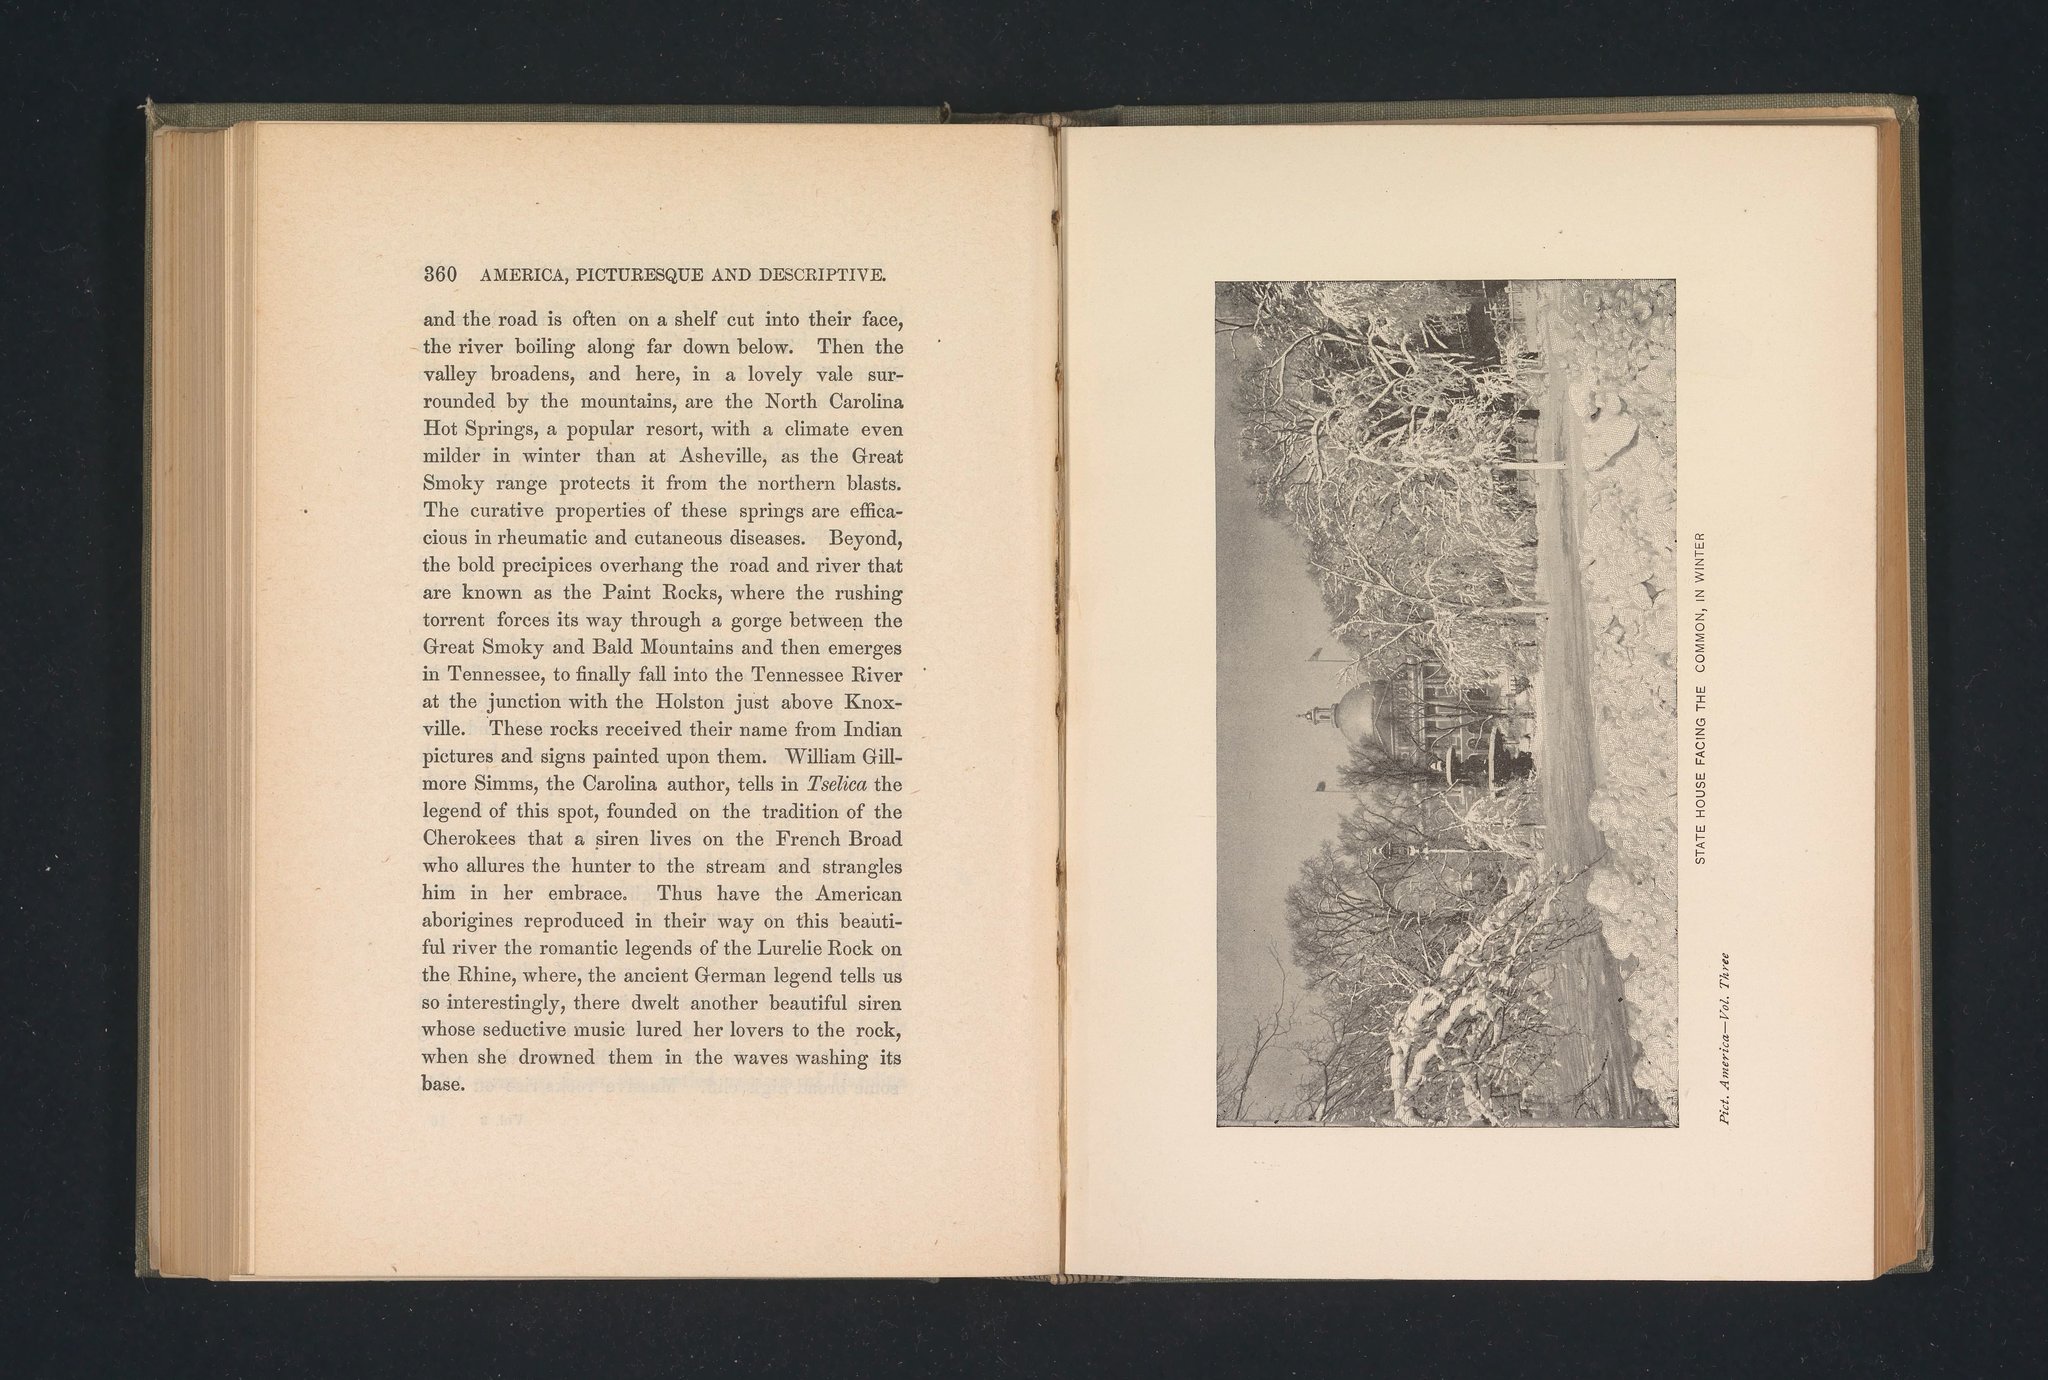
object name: page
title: State house facing the common, in Winter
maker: Anonymous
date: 1890-1900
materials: paper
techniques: autotype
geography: boston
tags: winter landscape; landscape symbolizing winter (the four seasons of the year), façade (of house or building), lower house, parliament, chamber